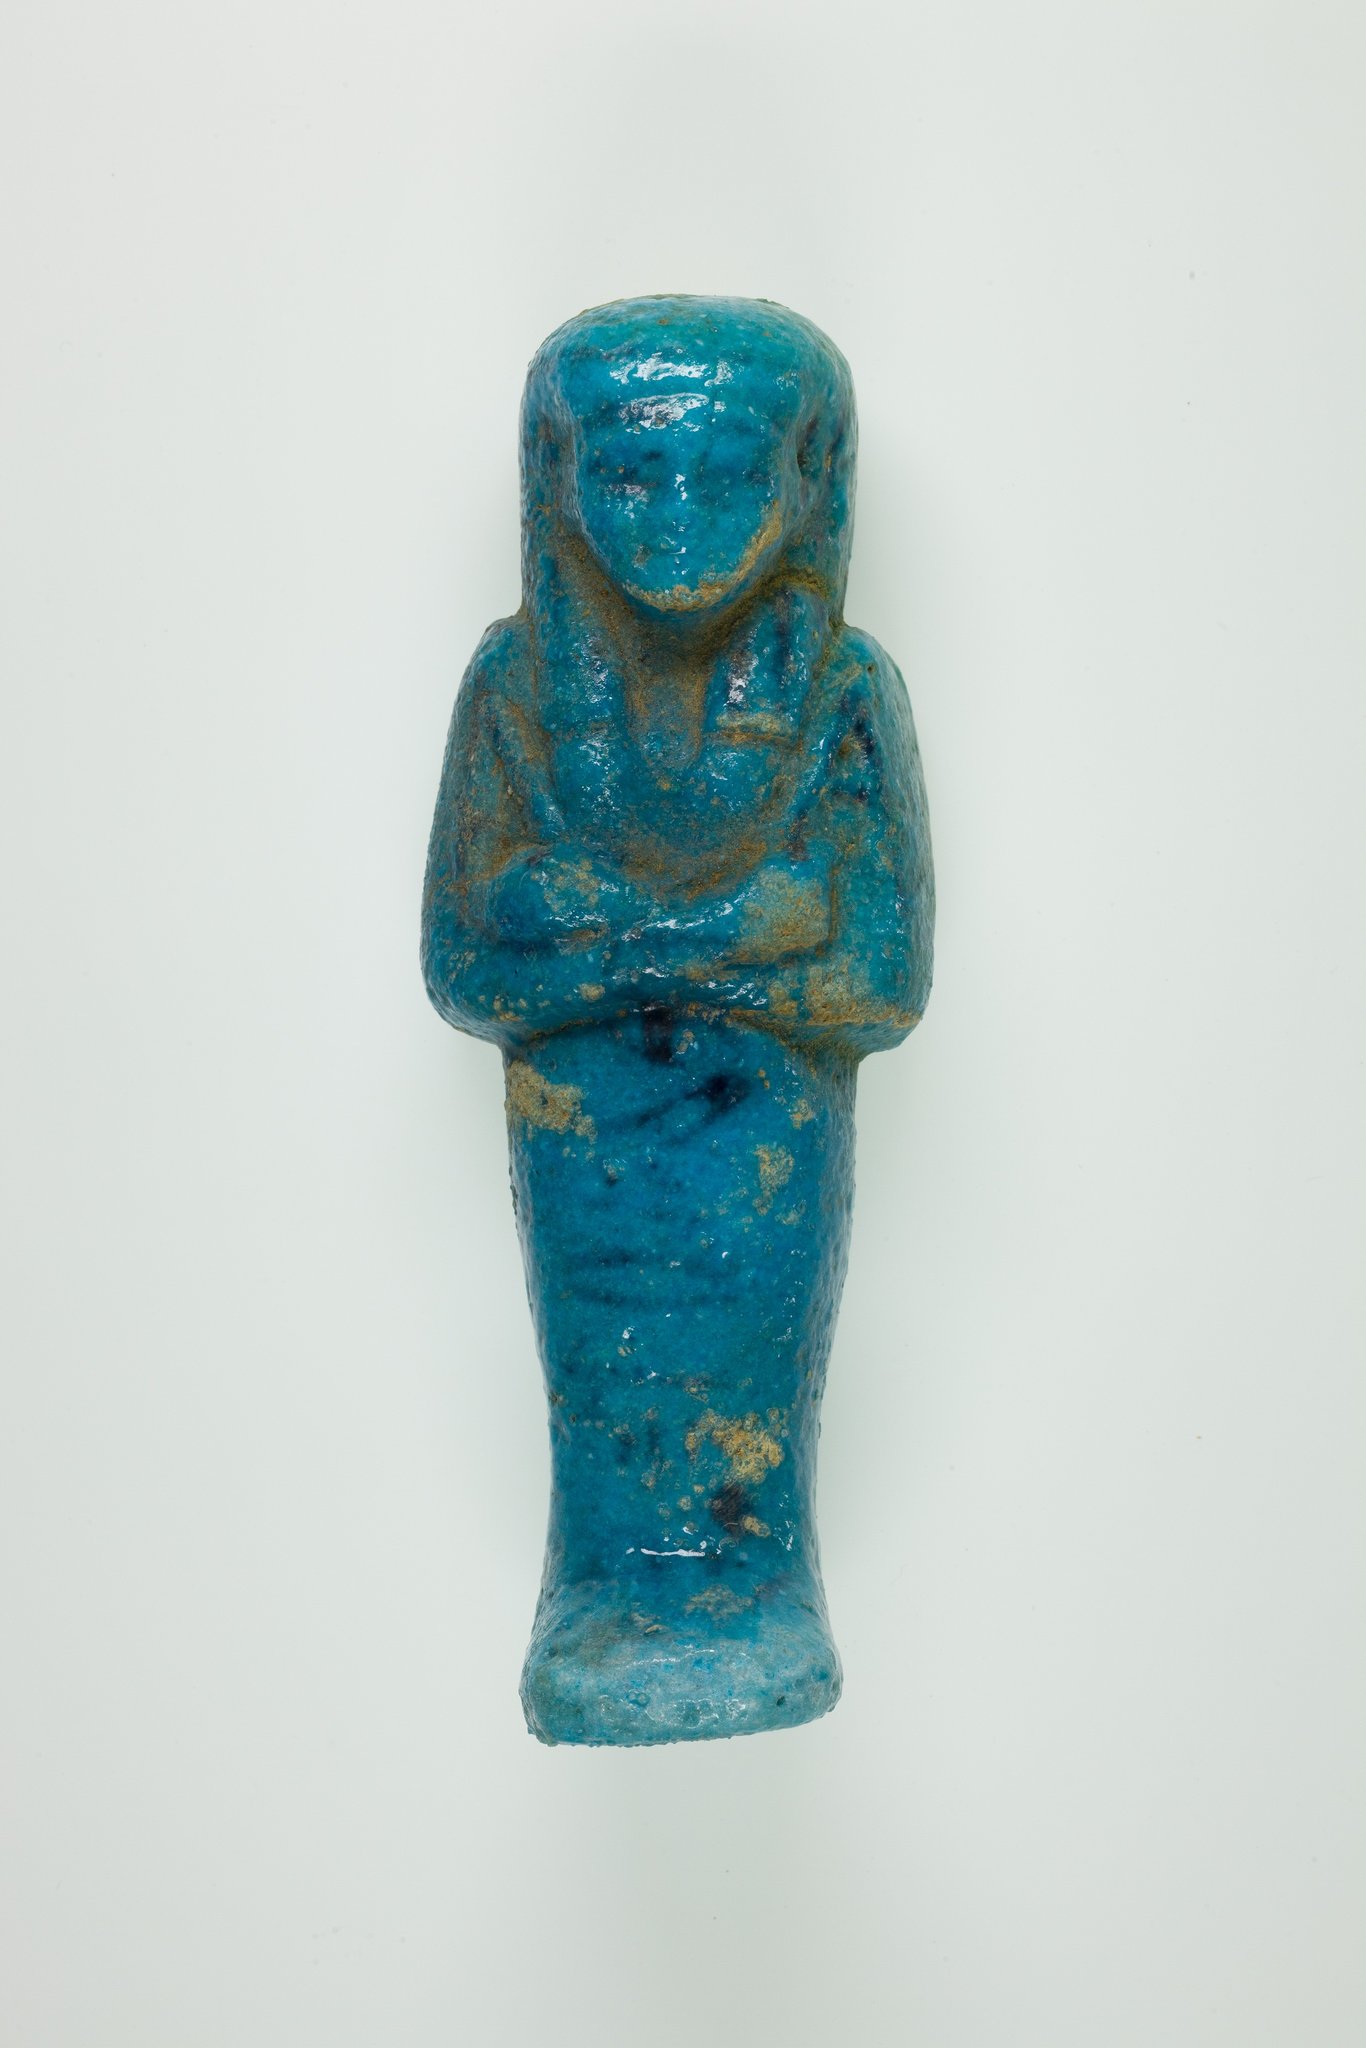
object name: worker shabti, henettawy c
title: Worker Shabti of Henettawy (C), Daughter of Isetemkheb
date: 990-970 BCE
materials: faience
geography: egypt